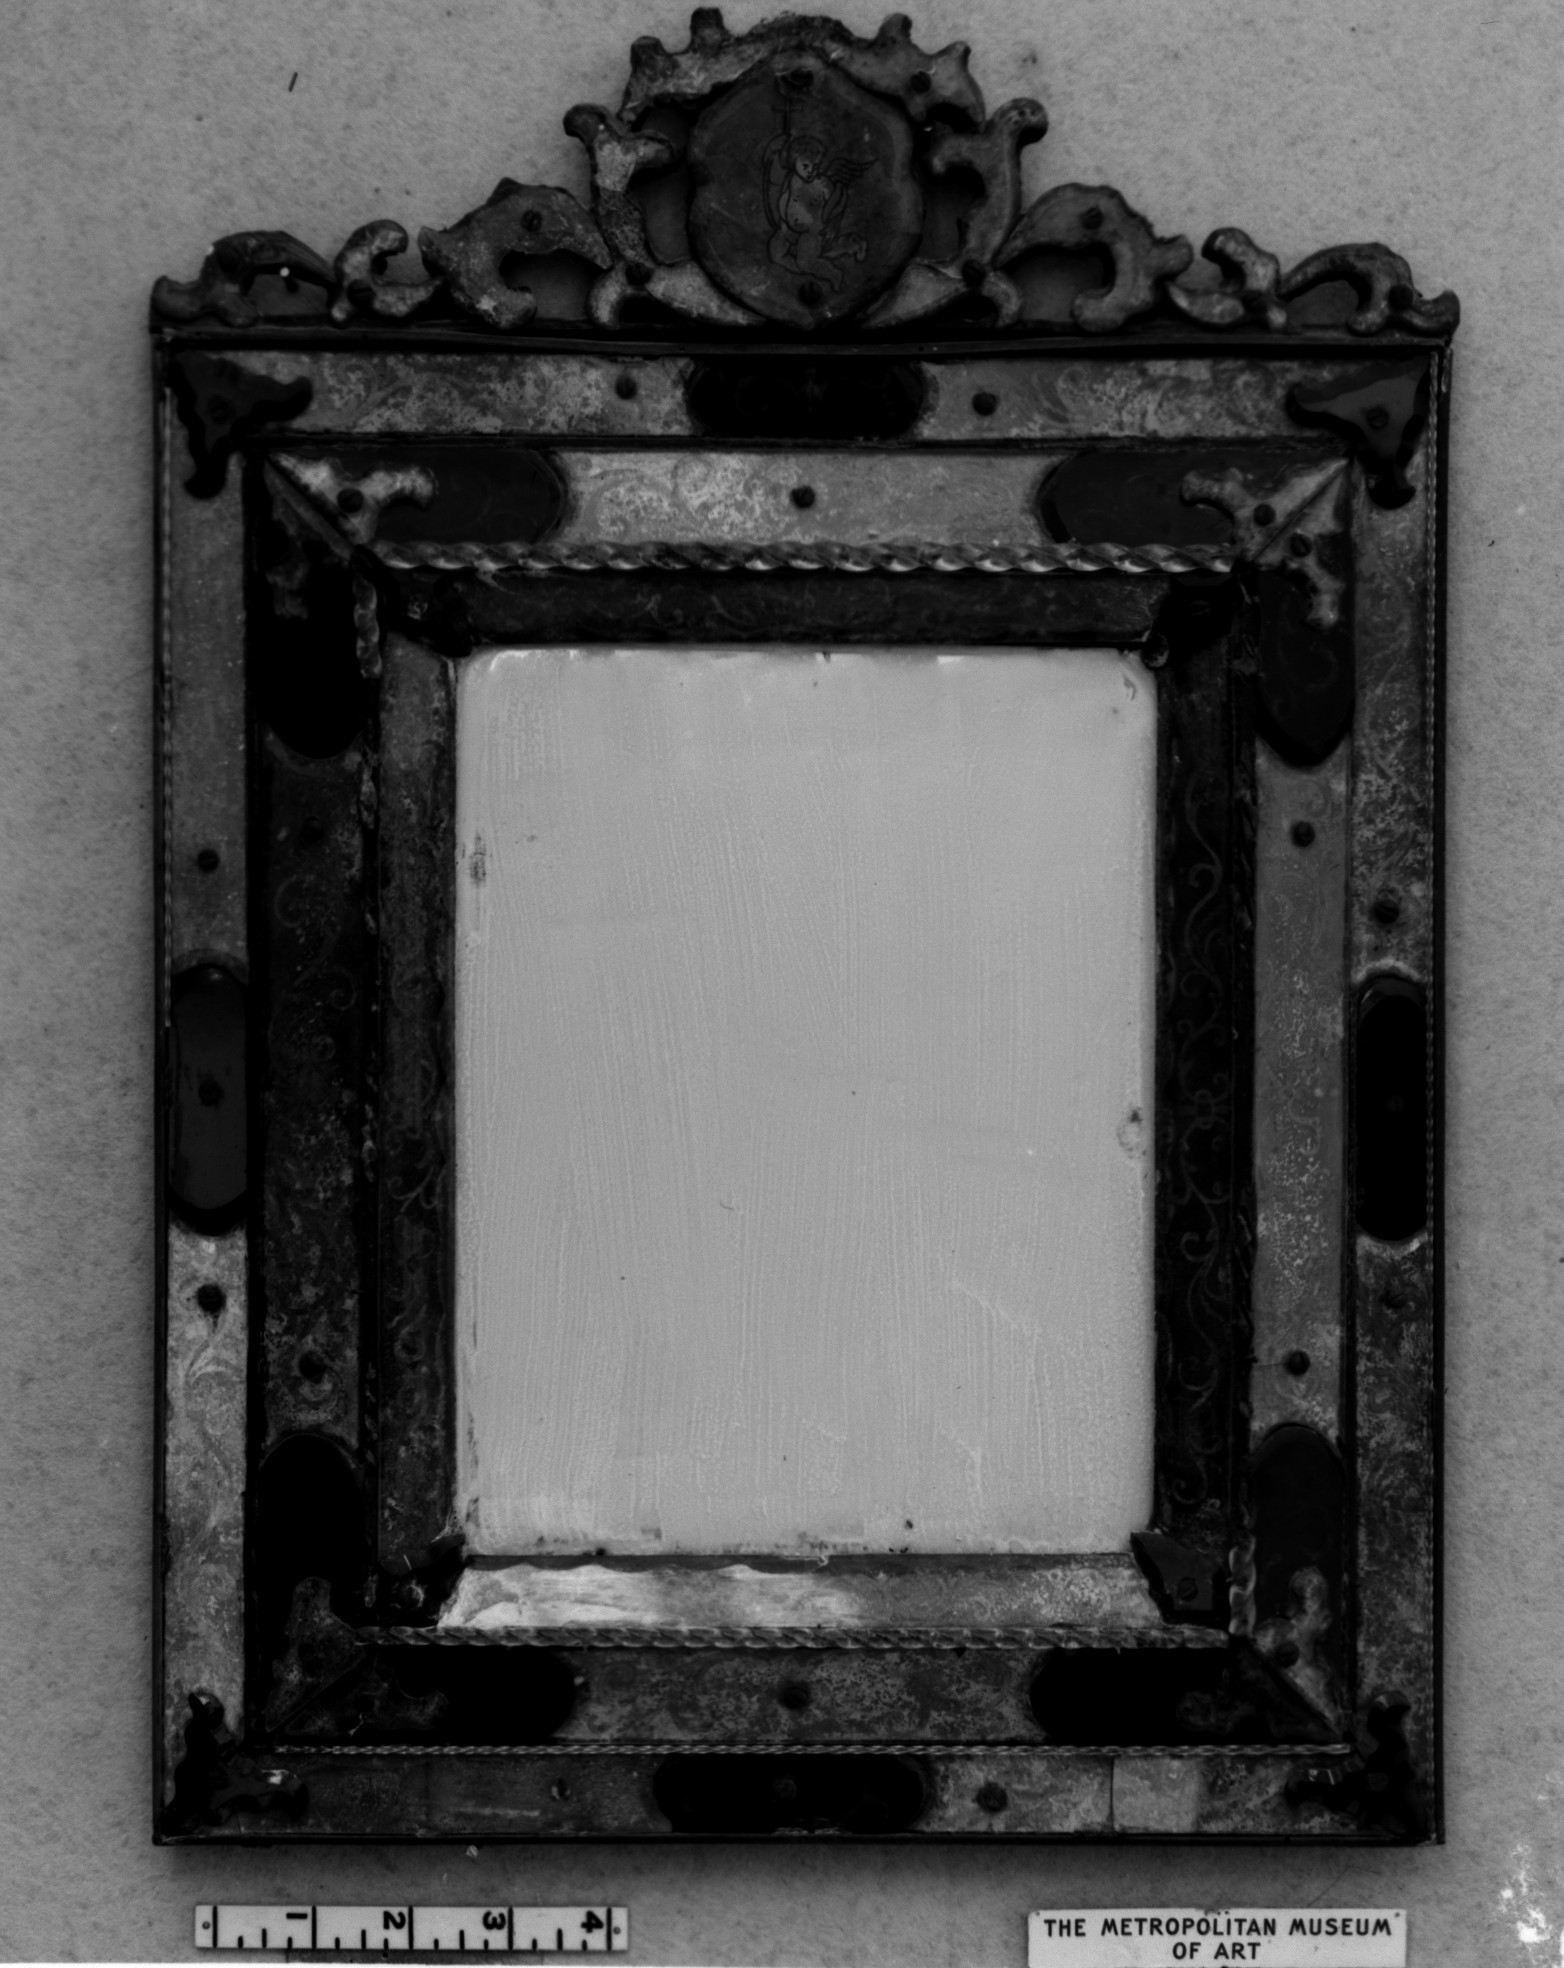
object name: mirror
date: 1601-1700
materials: glass